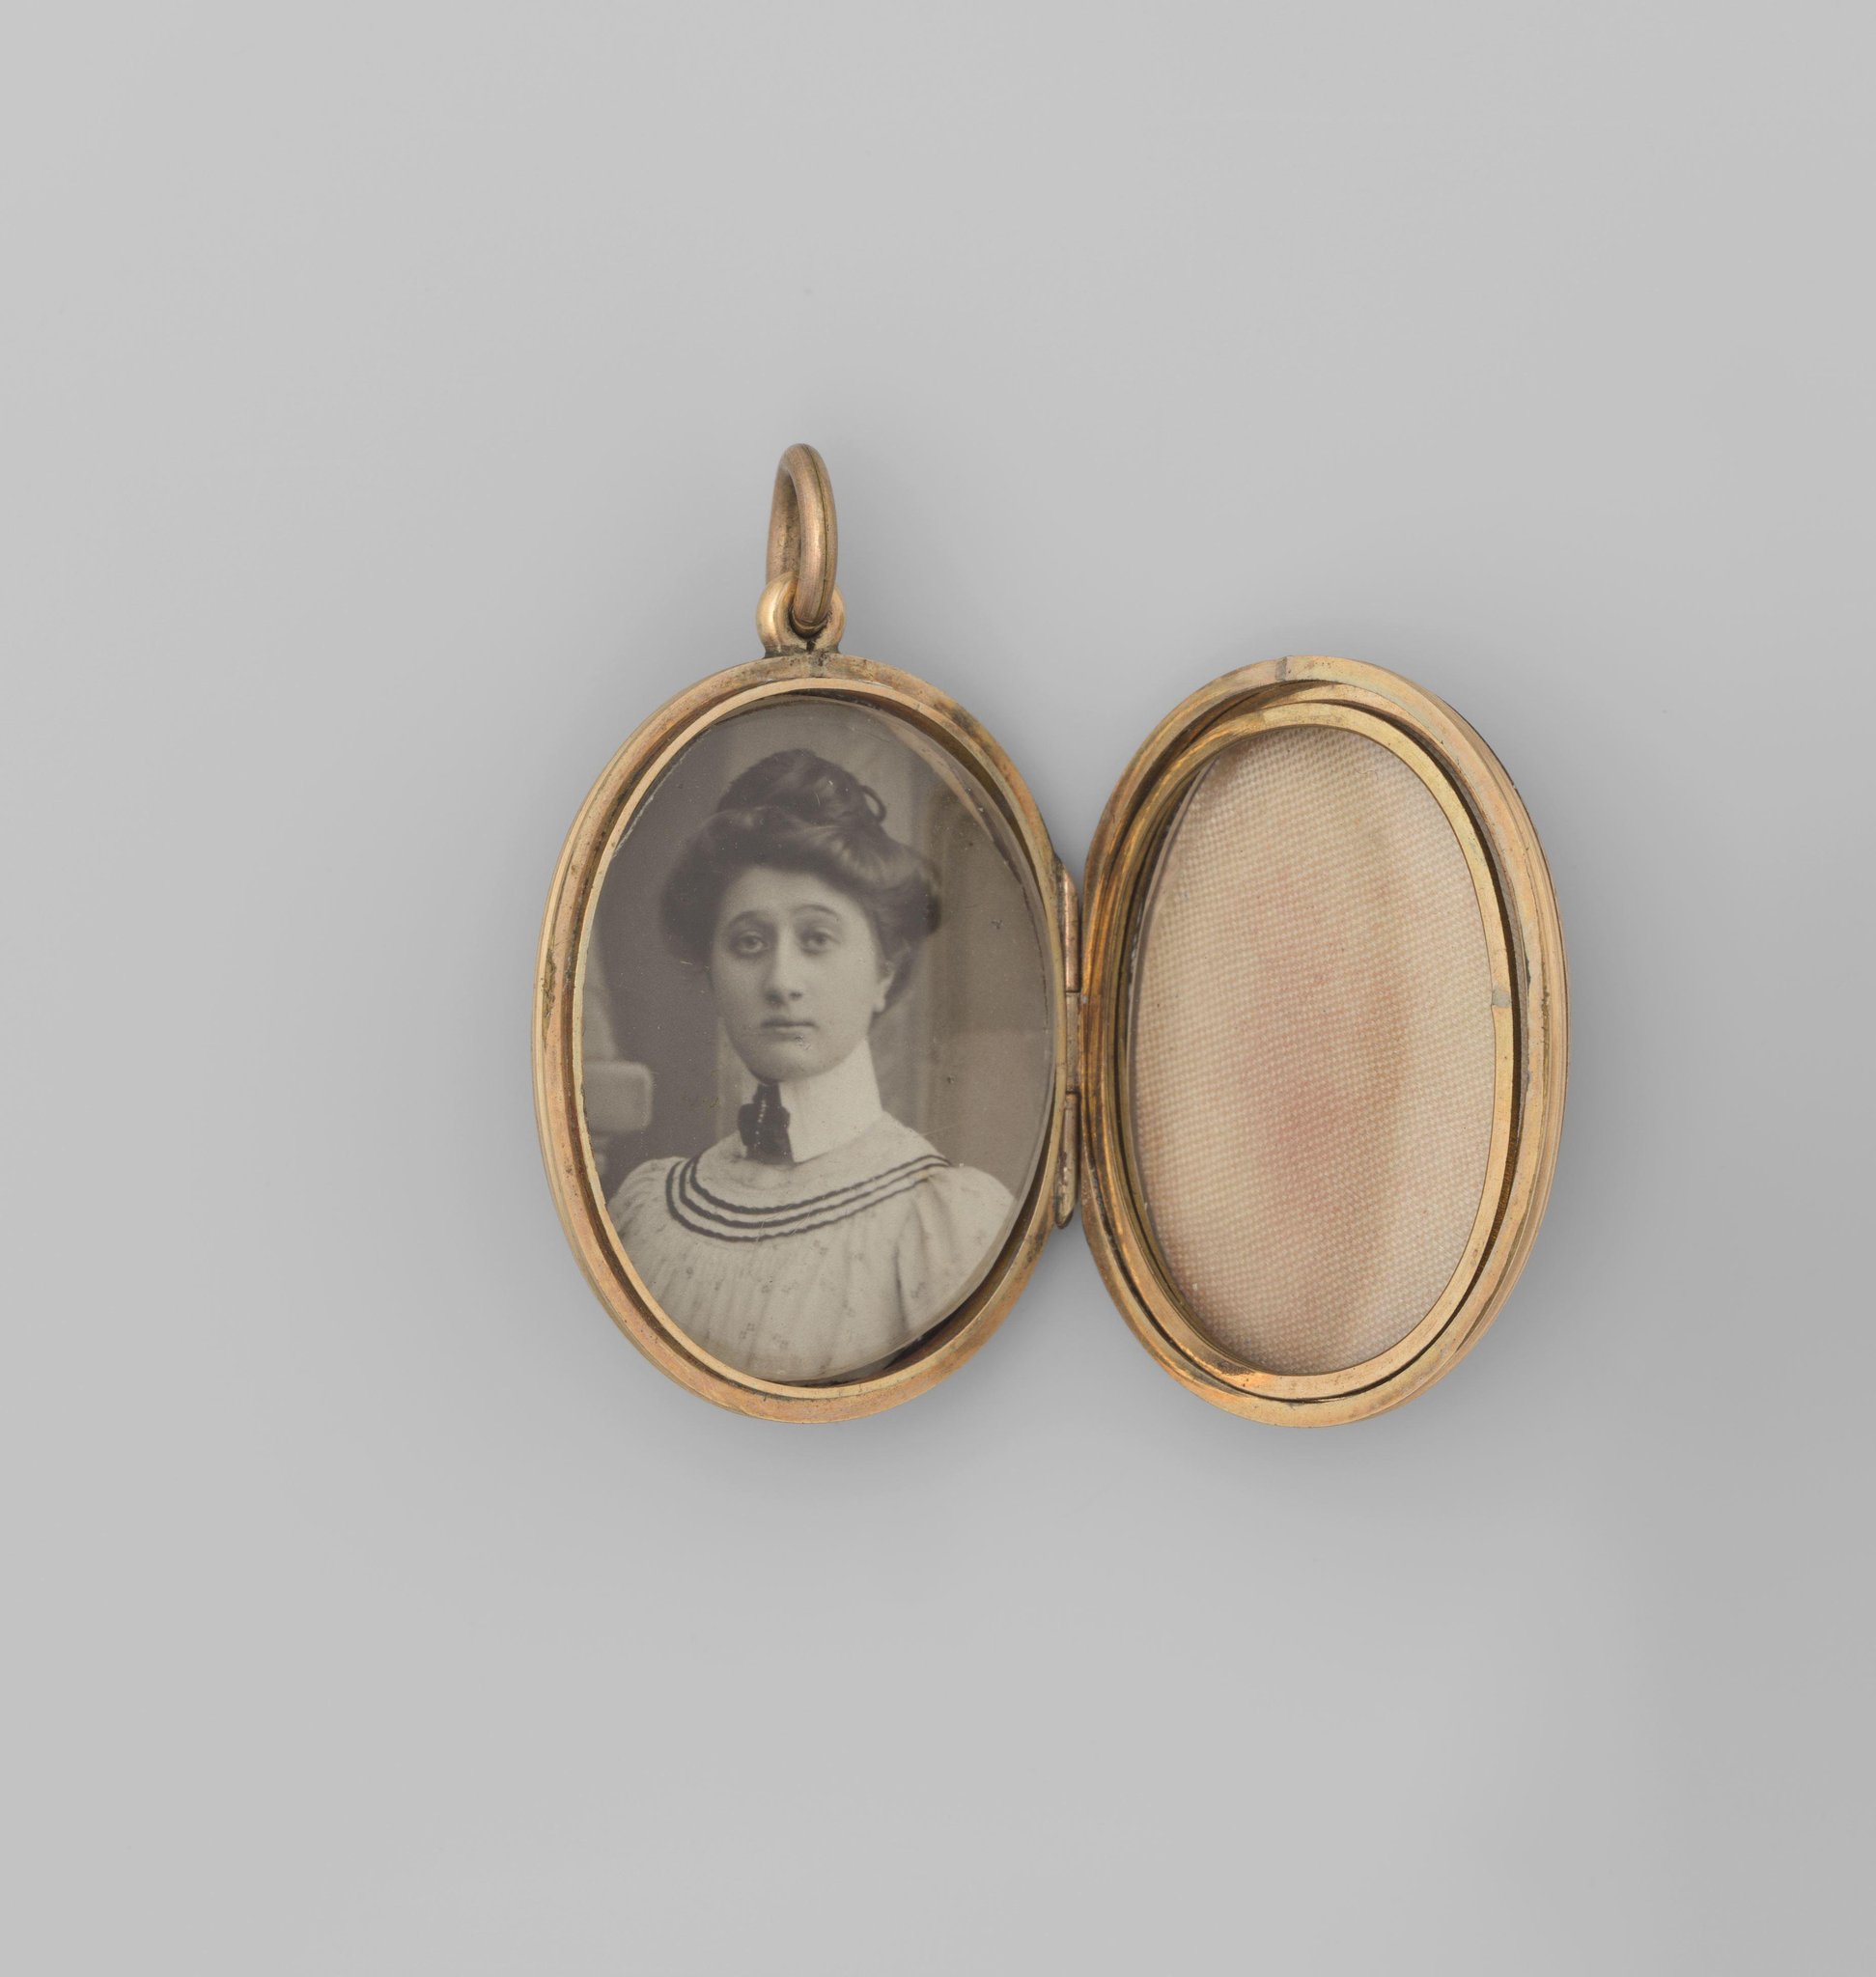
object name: locket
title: Portret van een onbekende vrouw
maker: Anonymous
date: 1880-1910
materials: paper, glass, lacquer, metal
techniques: gilding, lacquer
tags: anonymous historical person portrayed - bb - woman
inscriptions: inscription: ‘gekocht Juli 1970 f 38-/ [...] N. Spiegelstr A'dam/ verguld’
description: Portret van een onbekende vrouw in een medaillon met aan de buitenzijde de tekst 'In memory of'.